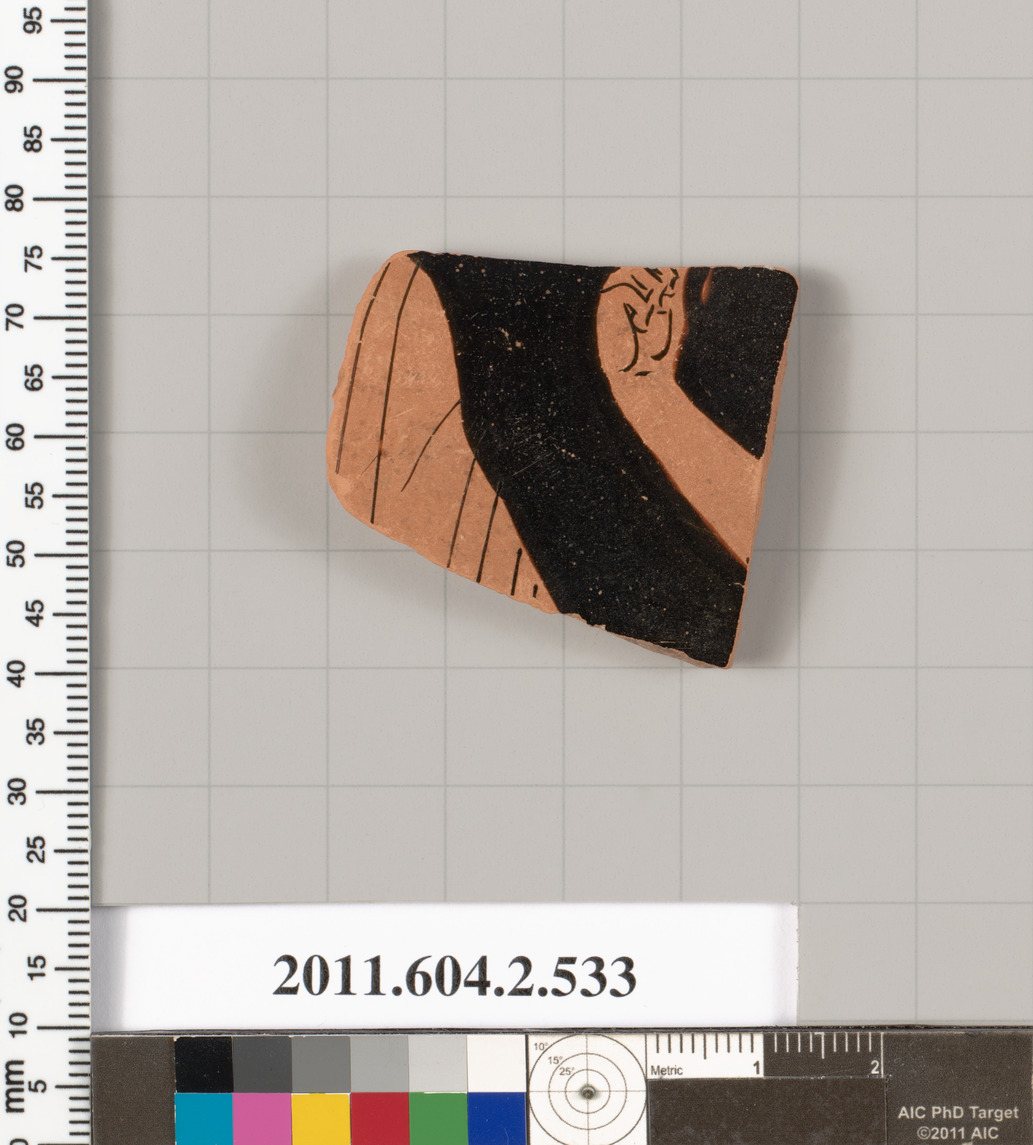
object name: column krater fragment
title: Terracotta fragment of a column-krater (bowl for mixing wine and water)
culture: greek, attic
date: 460-440 BCE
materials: terracotta